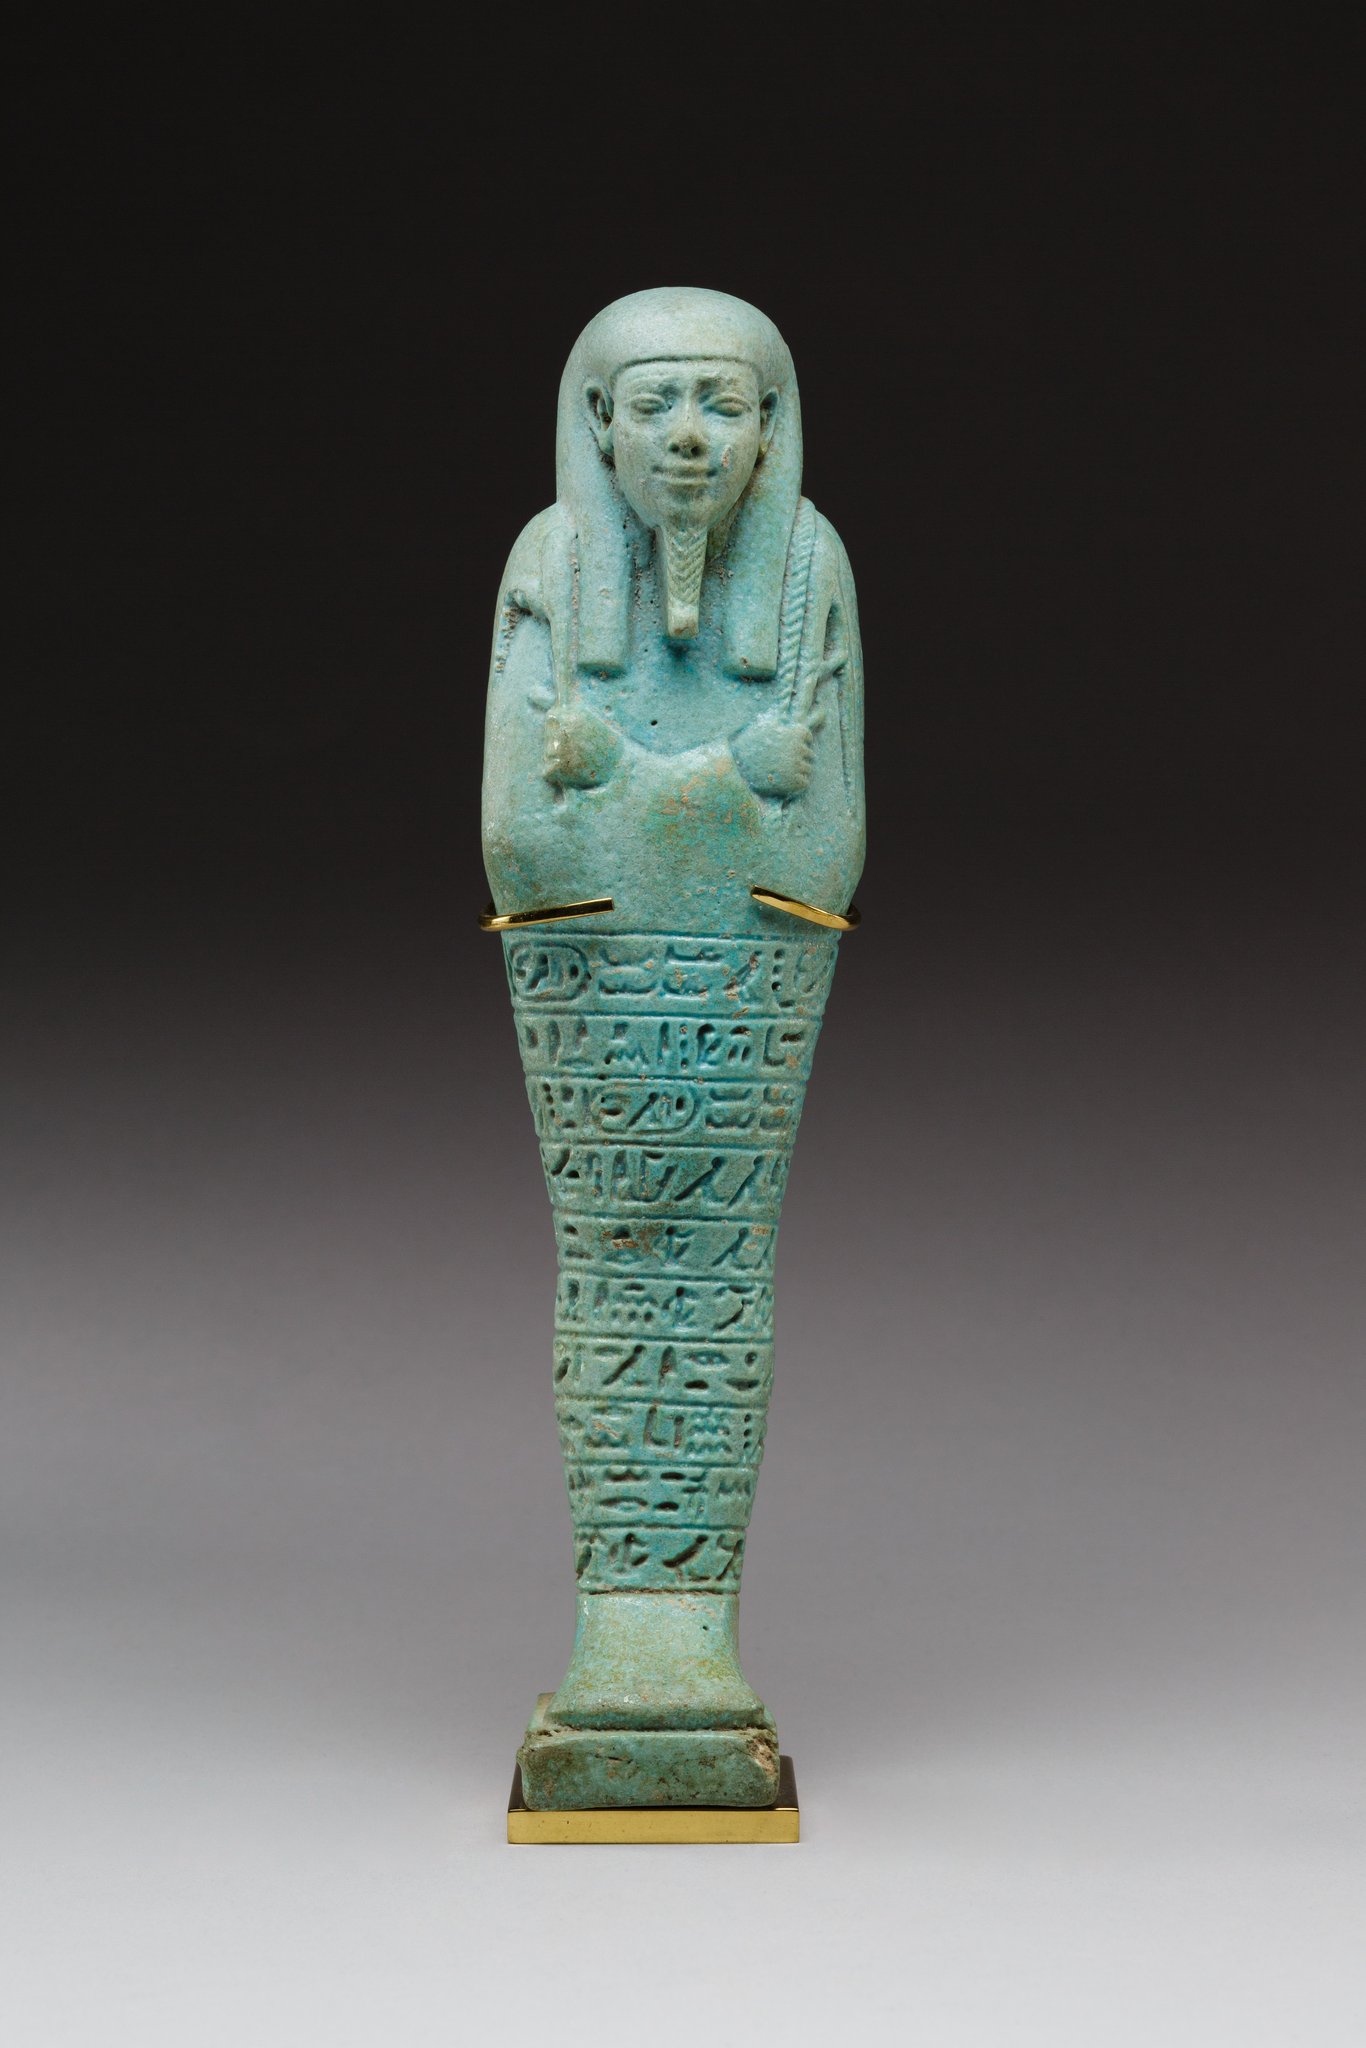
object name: shabti, psamtikmeryptah, overseer of boat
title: Shabti of Psamtikmeryptah, overseer of the royal fleet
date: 570-526 BCE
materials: faience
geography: egypt